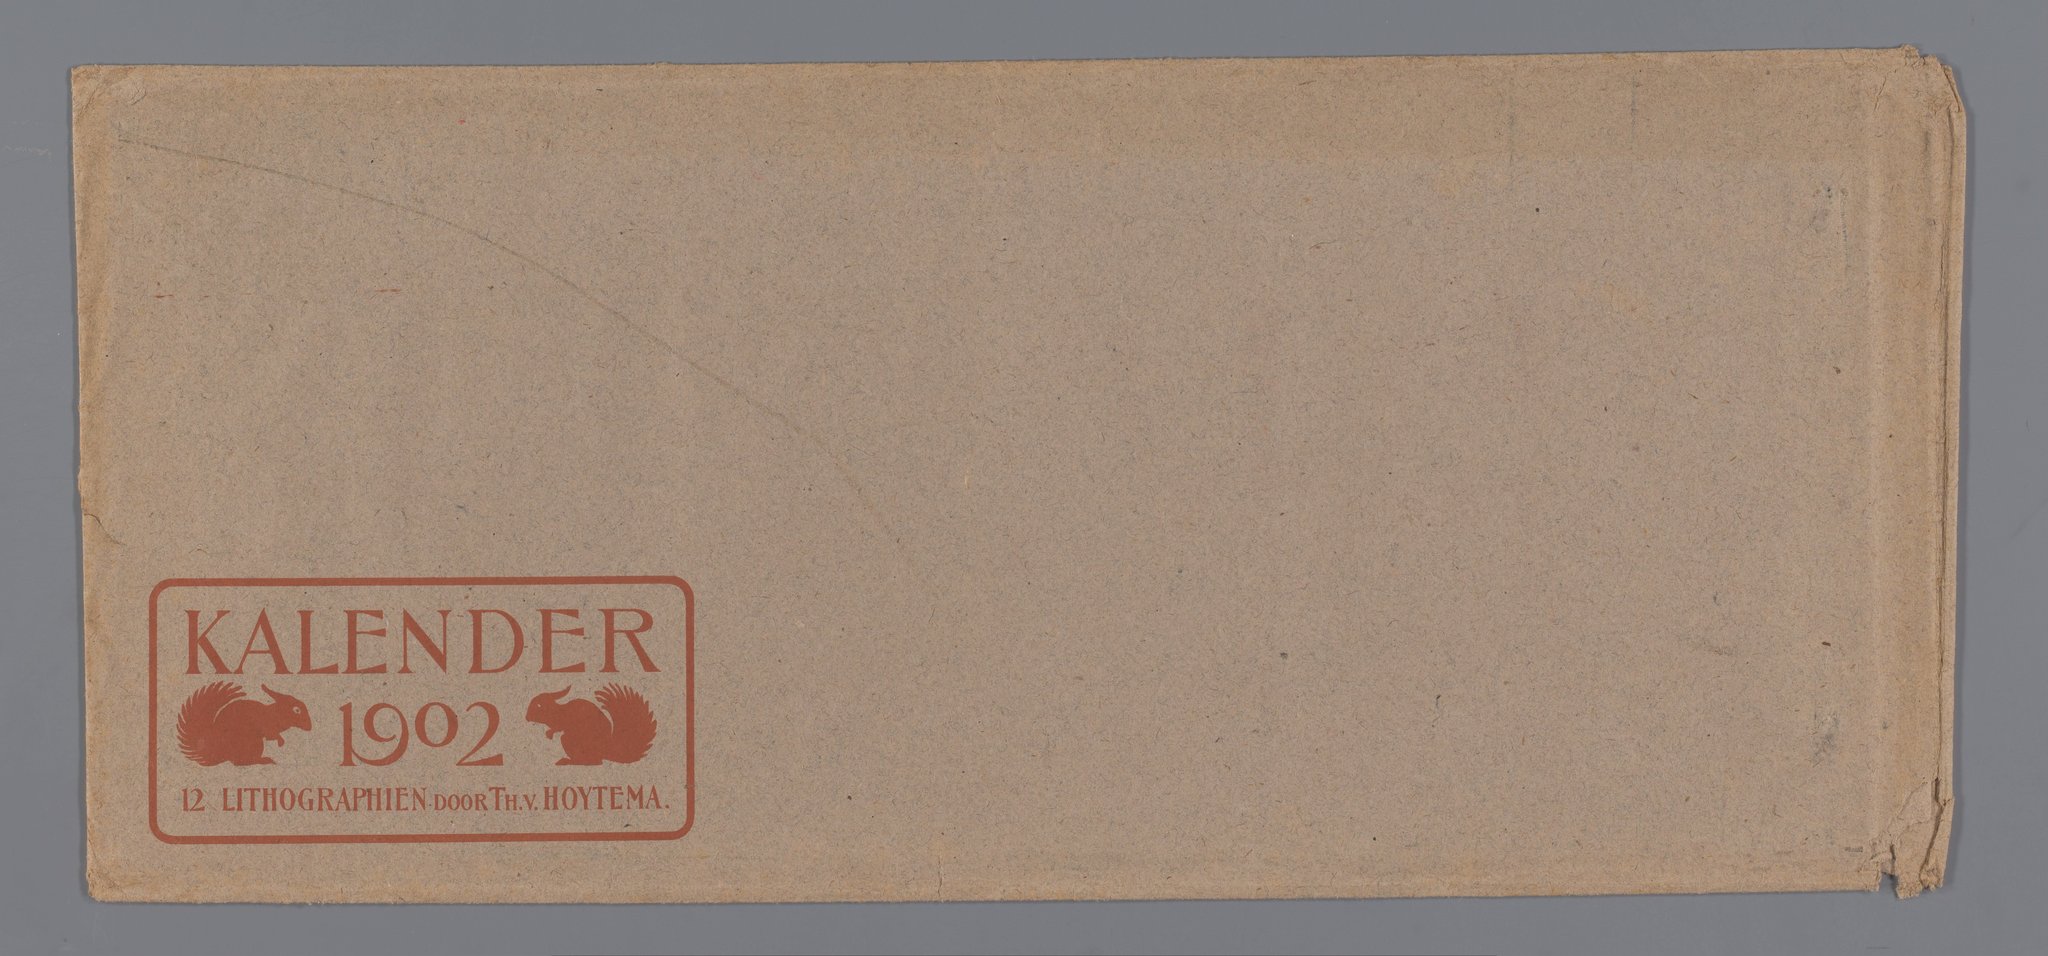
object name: envelope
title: Kalender 1902 12 lithografien door Th. v. Hoytema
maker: theo van hoytema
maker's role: draughtsman, painter, print maker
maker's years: 1863-1917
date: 1901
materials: paper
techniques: lithograph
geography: hilversum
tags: rodents: squirrel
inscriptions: collector's mark: Lugt 2228, collector's mark: Lugt 2760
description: Ook de bladen van deze kalender bevinden zich de collectie, zie nummers RP-P-1980-89, RP-P-1974-219 t/m 229 en RP-P-1977-410.